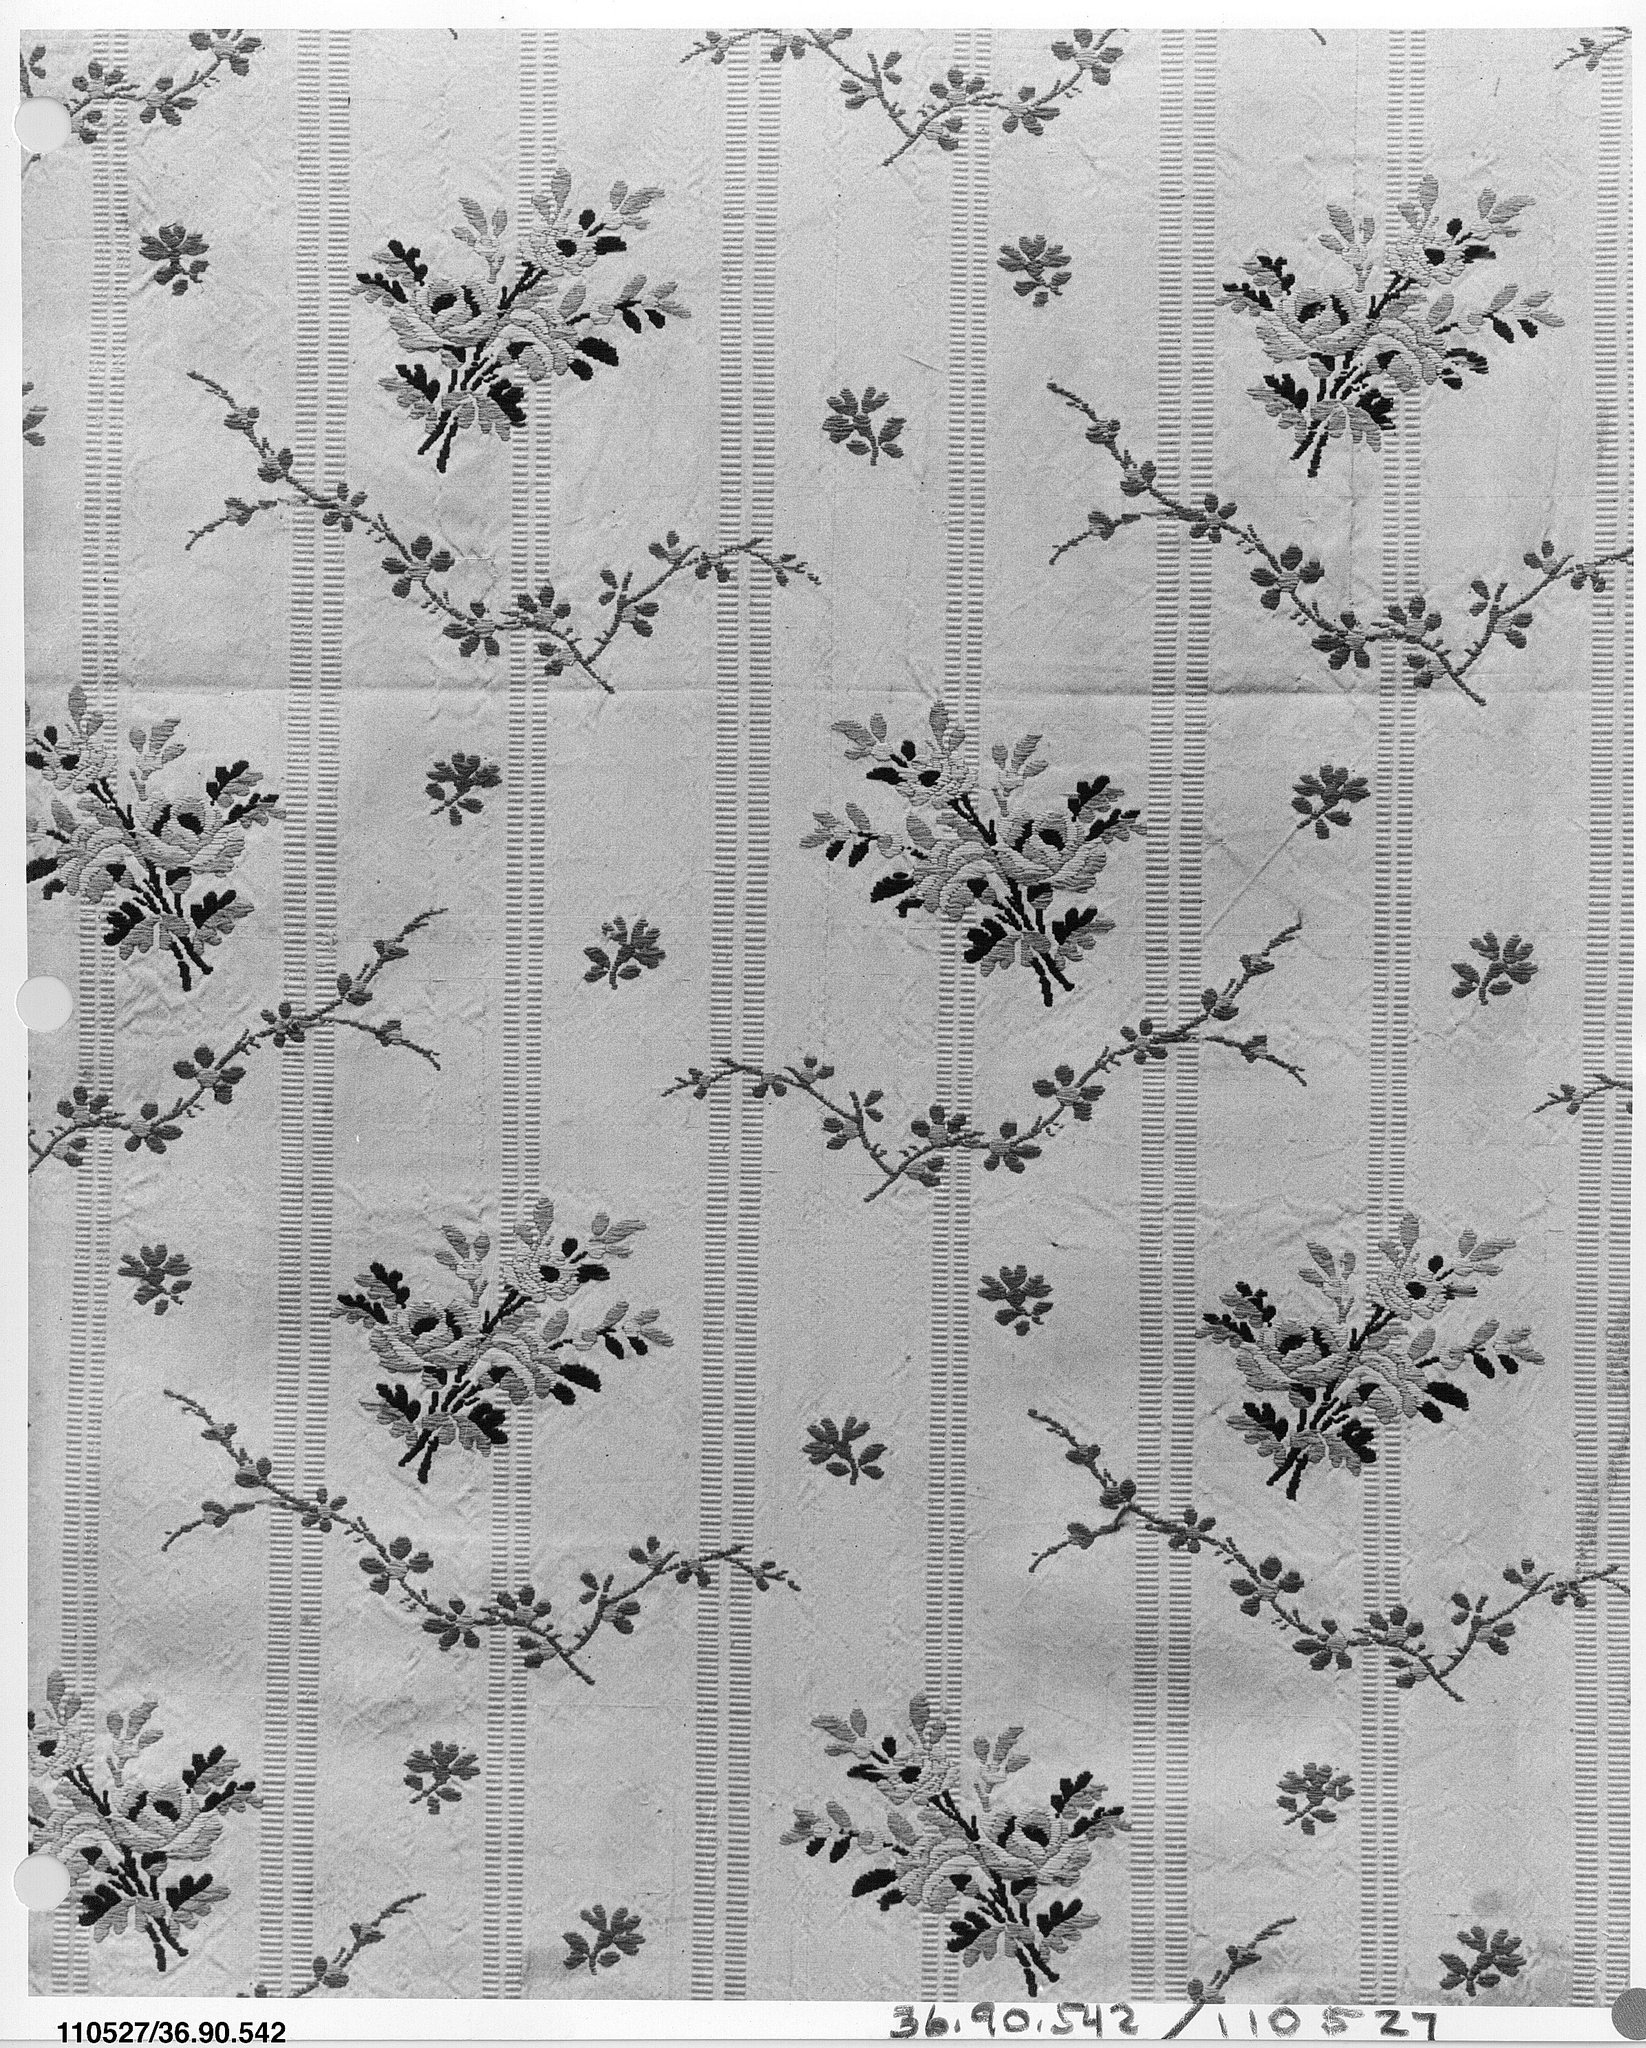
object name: piece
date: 1701-1800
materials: silk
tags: flowers,leaves